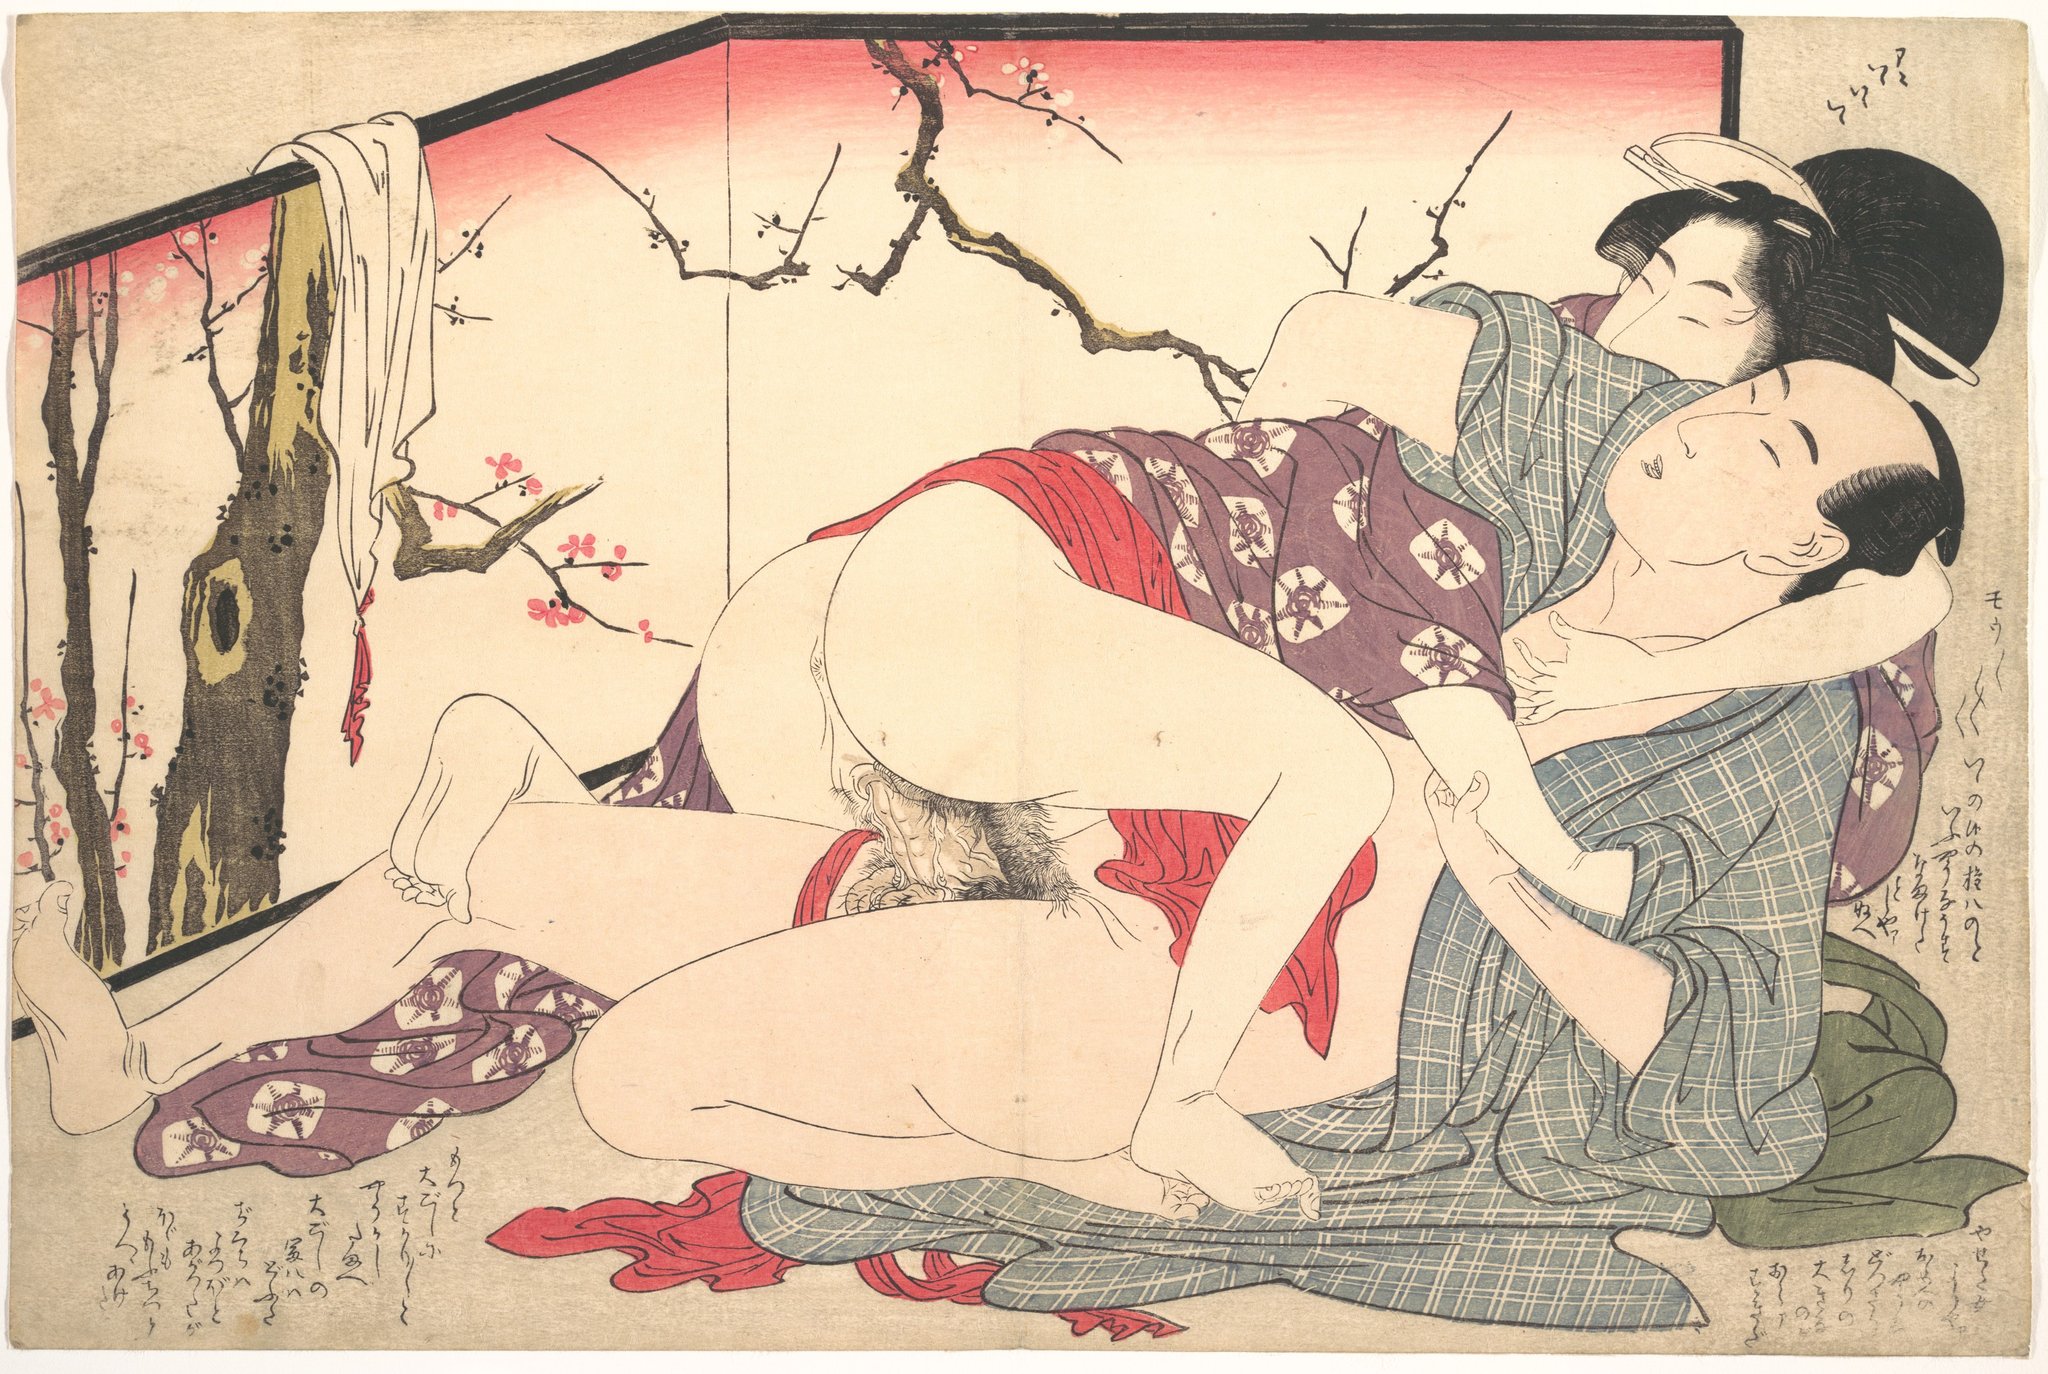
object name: print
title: Erotic Print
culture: japanese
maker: kitagawa utamaro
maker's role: artist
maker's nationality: japanese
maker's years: 1754-1806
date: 1753-1806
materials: ink, paper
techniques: woodblock print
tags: male nudes,female nudes